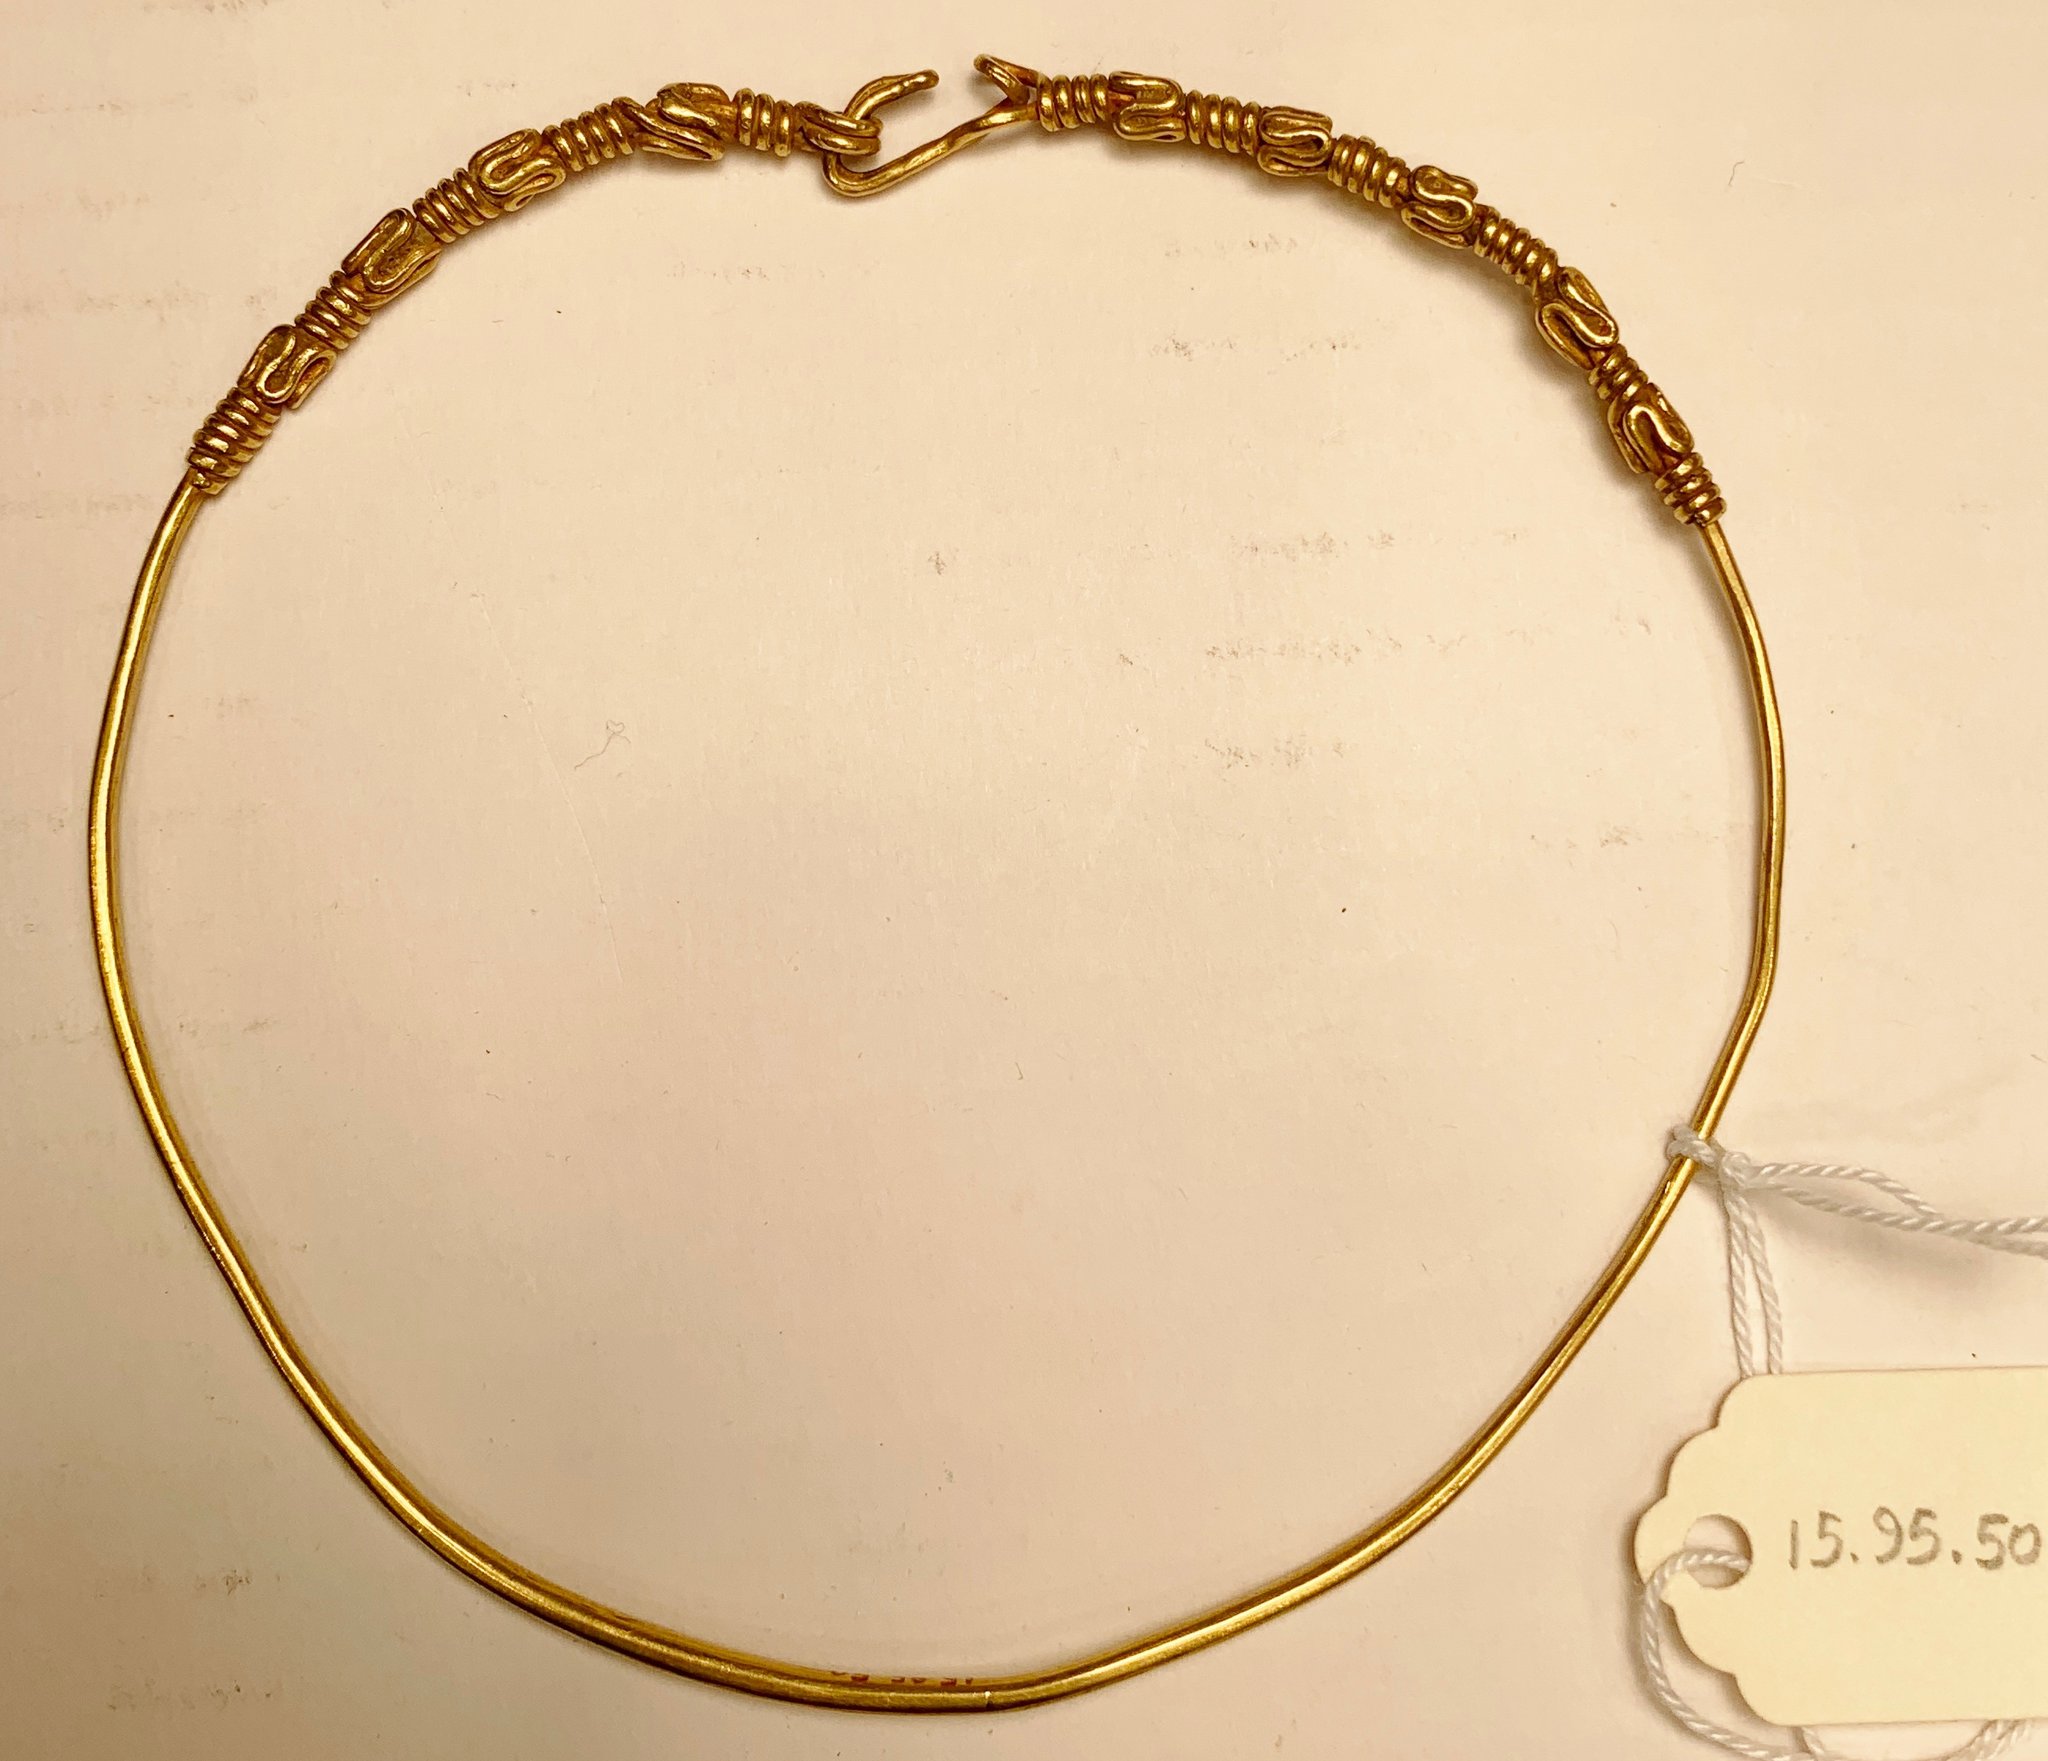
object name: necklet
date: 1701-1900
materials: gold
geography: india